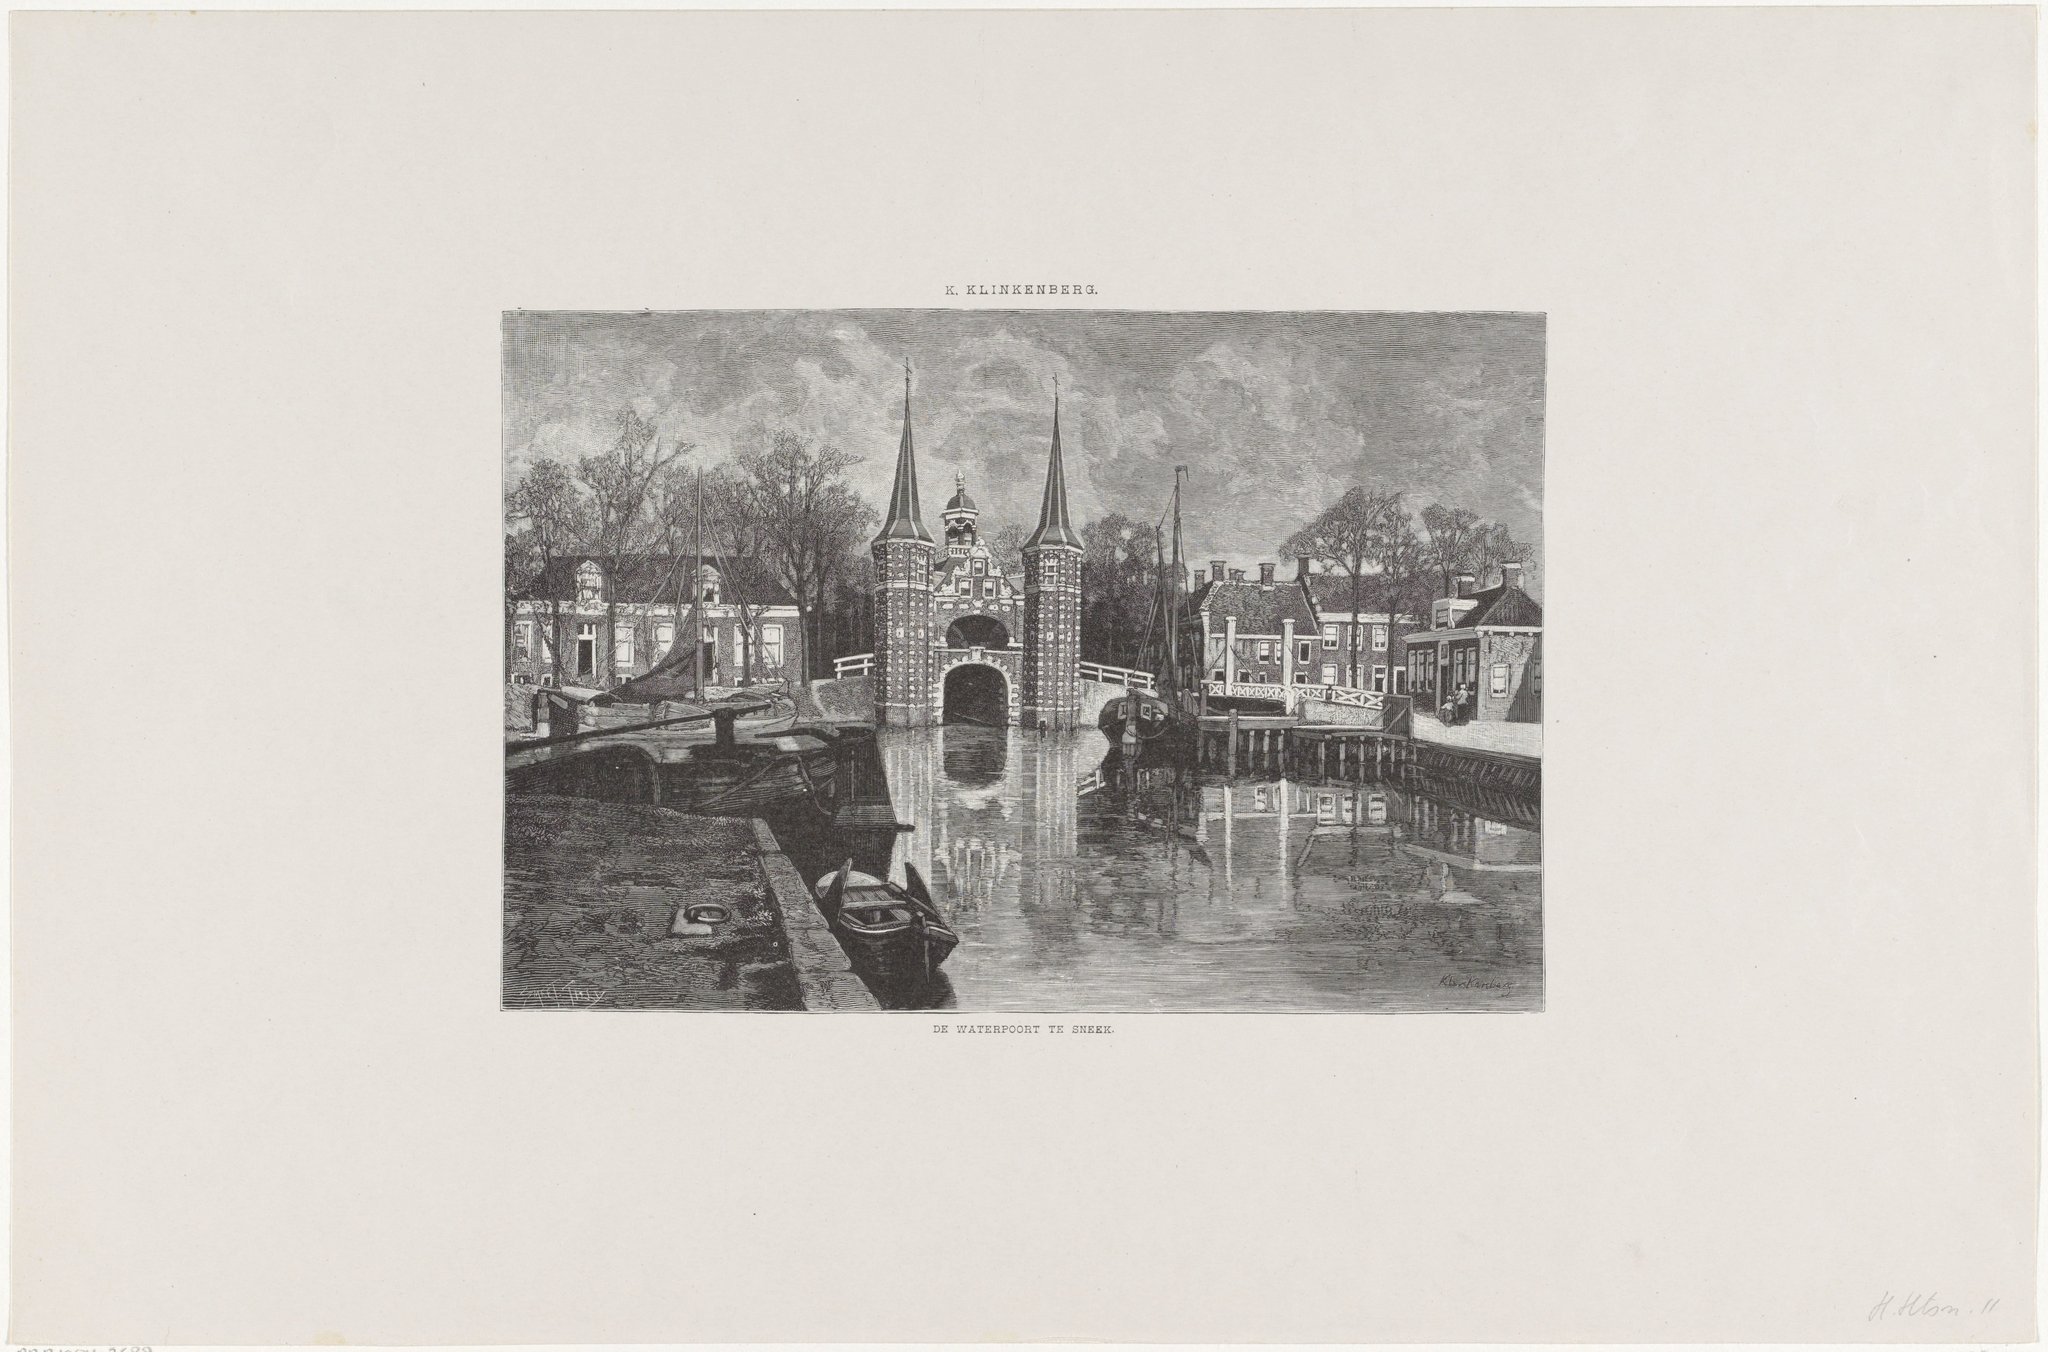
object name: print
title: De waterpoort te Sneek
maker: johannes christiaan karel klinkenberg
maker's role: draughtsman, painter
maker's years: 1852-1924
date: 1874-1888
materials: paper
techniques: engraving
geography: paris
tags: ships (in general), village-gate, bridge in village across river, canal, etc.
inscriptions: collector's mark: Lugt 2228